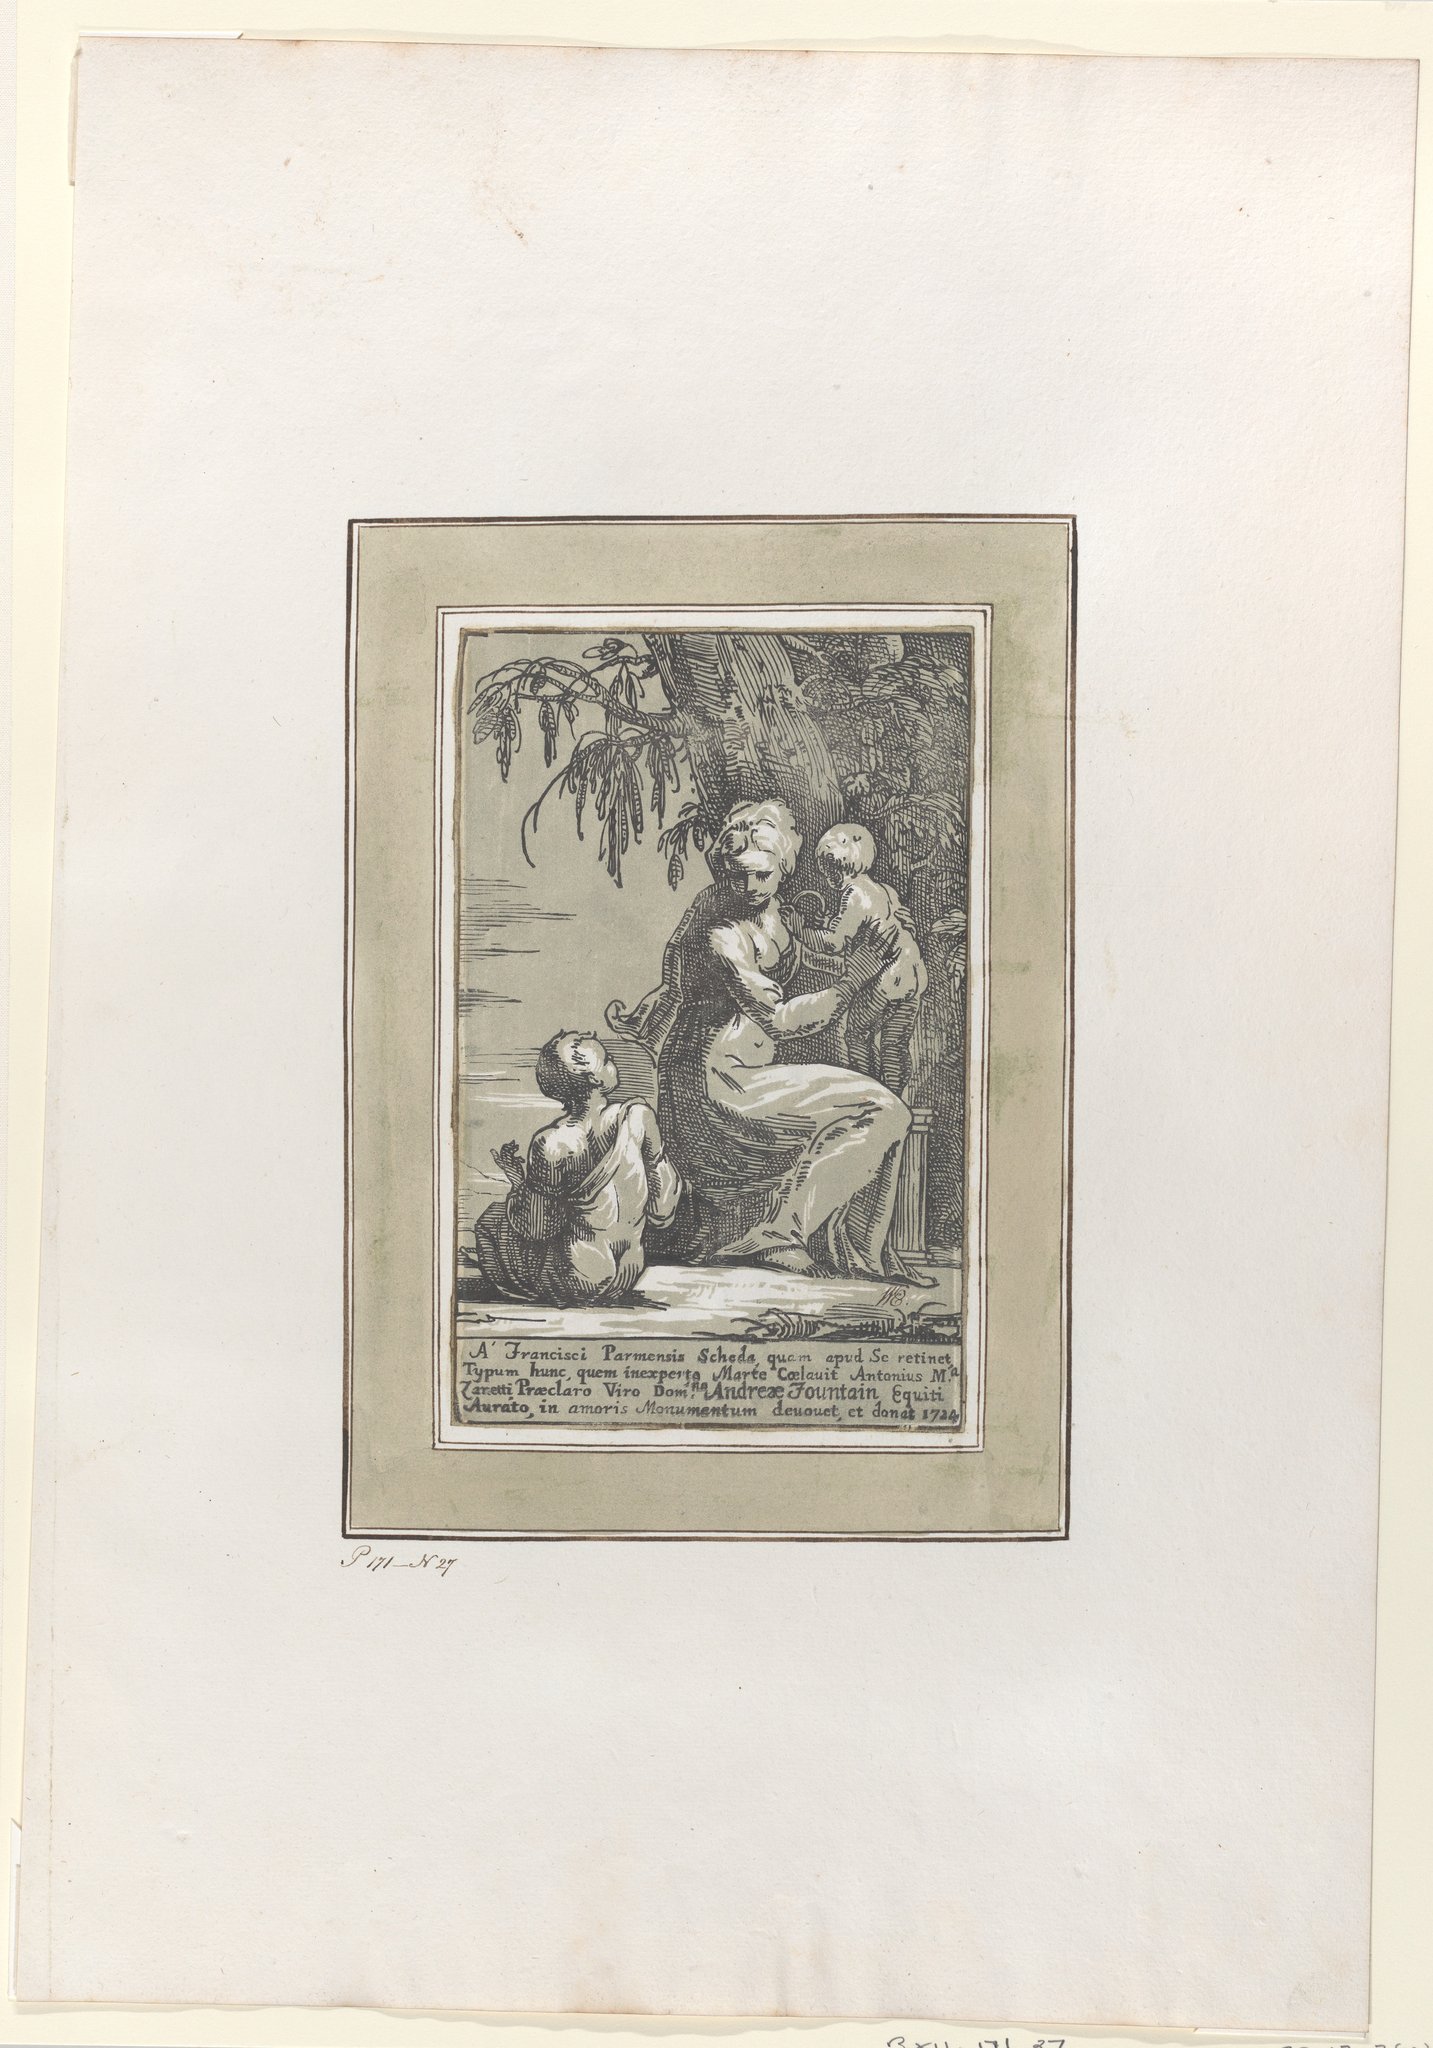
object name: print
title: A Woman Standing at the Foot of a Tree Holding an Infant, with a Seated Boy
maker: conte anton maria zanetti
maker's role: artist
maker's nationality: italian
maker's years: 1680-1767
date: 1724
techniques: woodcut, line block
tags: children,infants,women